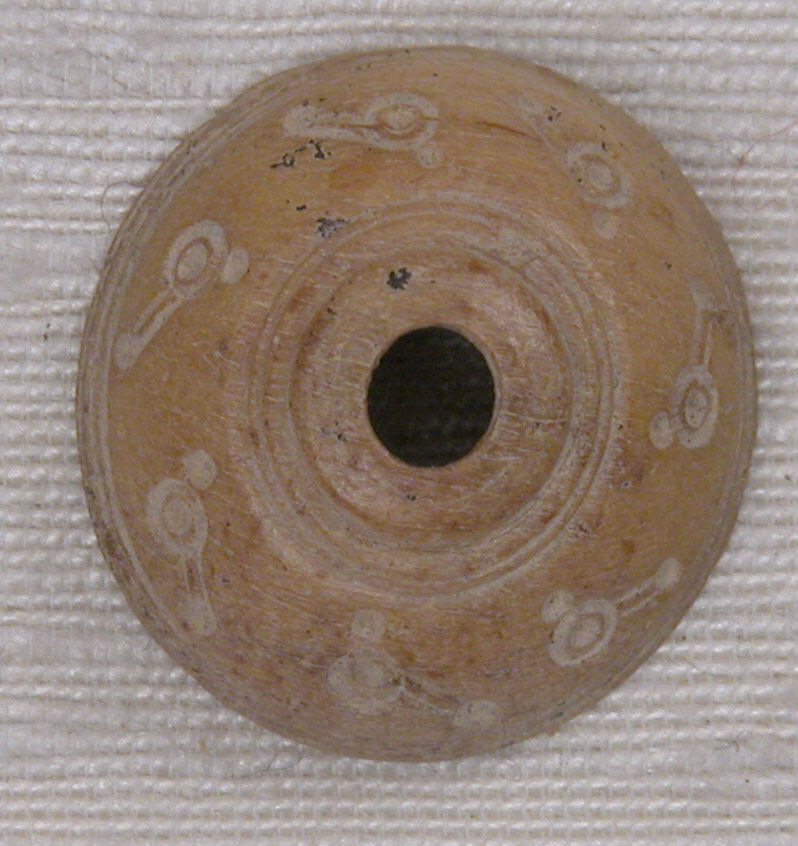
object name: button or bead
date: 801-1000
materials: bone, paint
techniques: incising, inlay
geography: iran